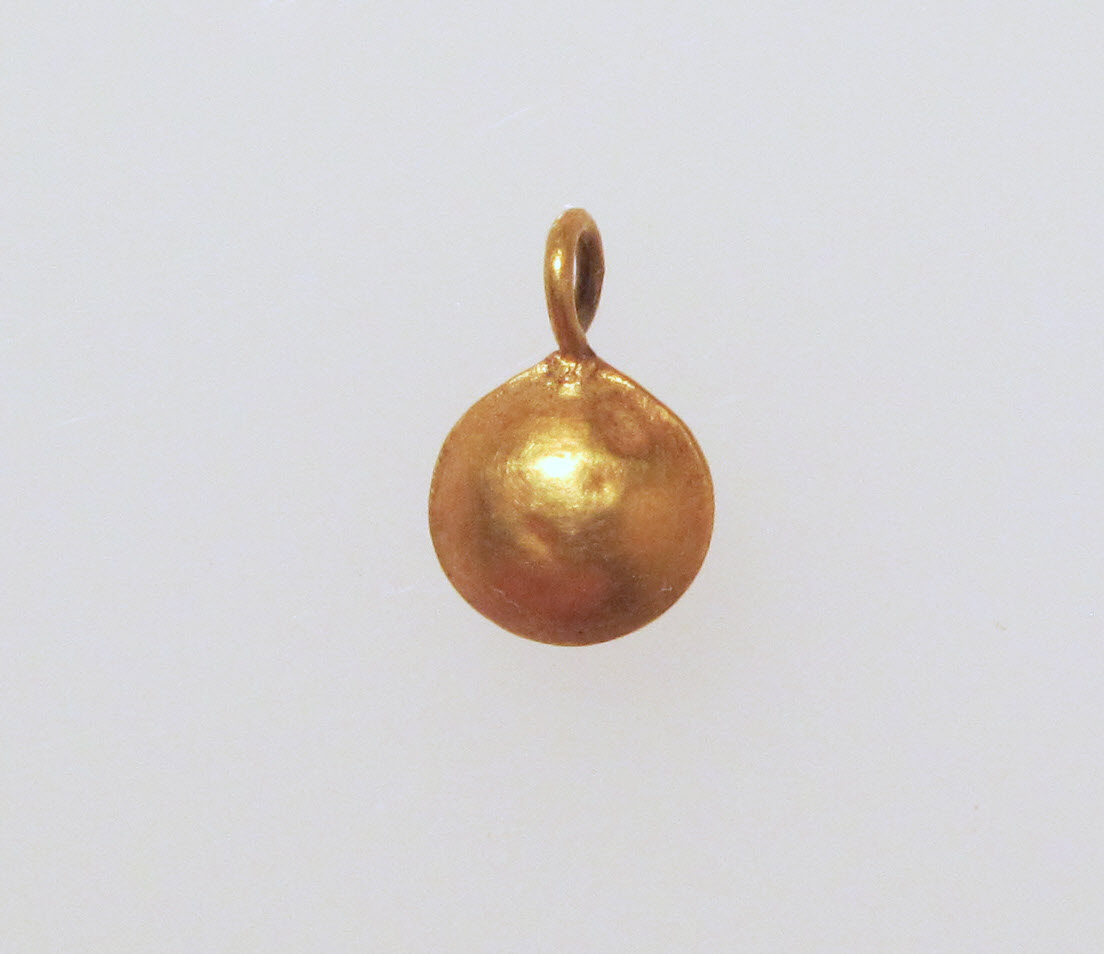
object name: pendant, lentoid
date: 7000 BCE-330 CE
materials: gold